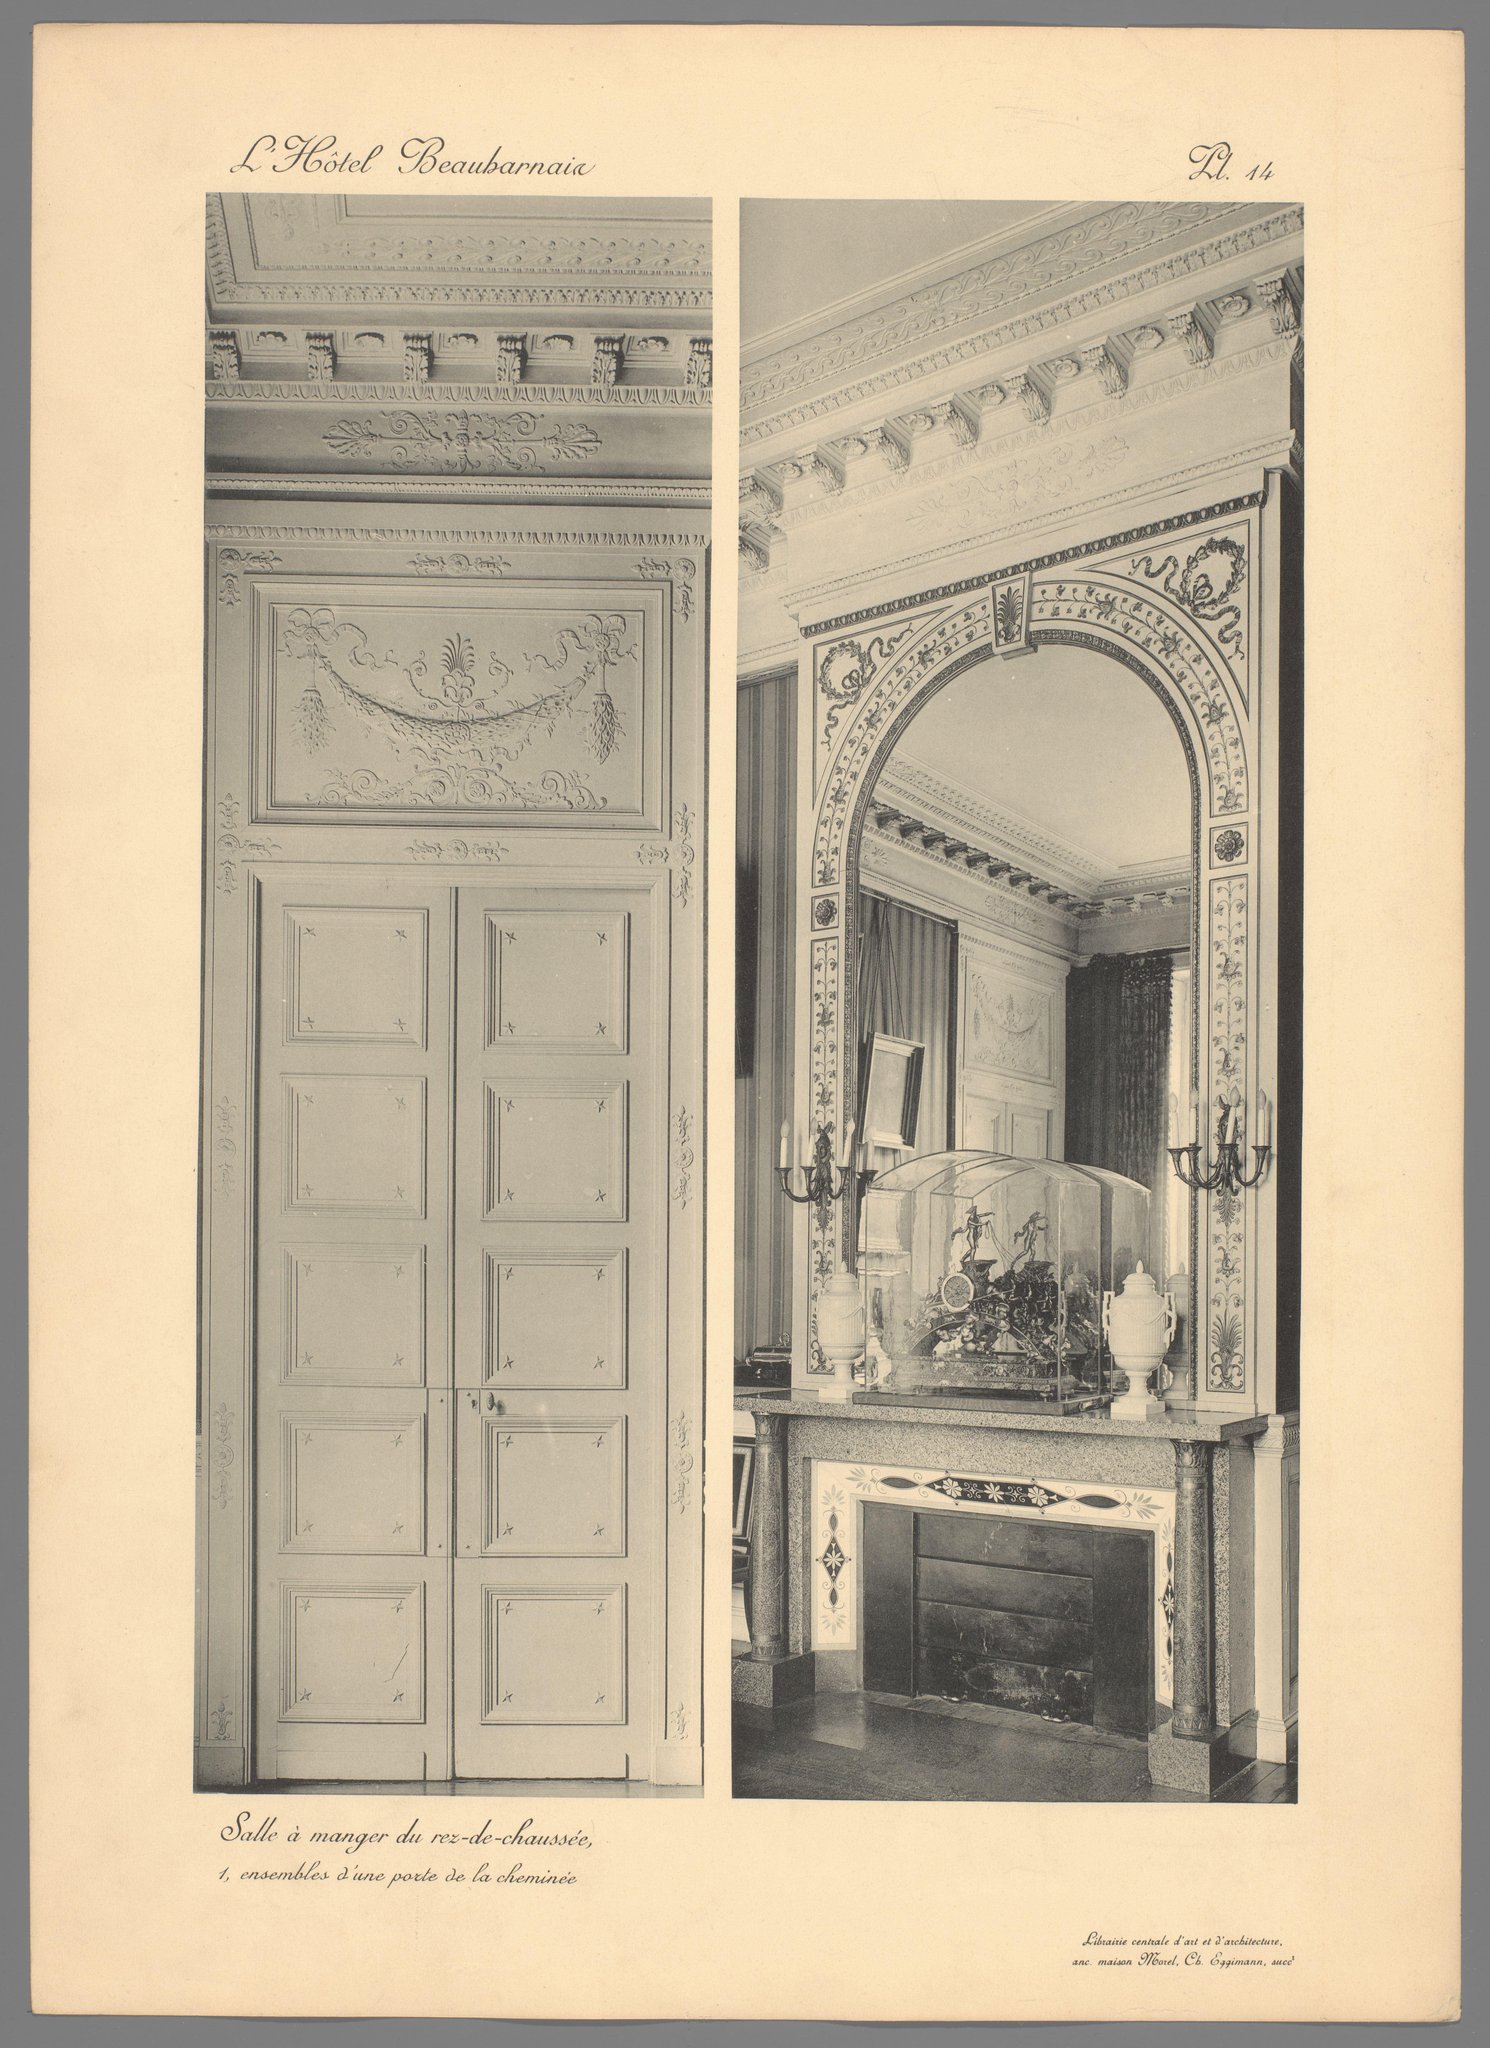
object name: photomechanical print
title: Gezicht op een deel van de eetzaal en de deur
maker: Anonymous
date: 1875-1930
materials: paper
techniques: photograph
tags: door, communal rooms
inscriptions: collector's mark: ‘Rijks normaalschool voor teekenonderwijzers Amsterdam’, number: ‘14’, inscription: ‘1. ensemble d'une porte de la cheminée’